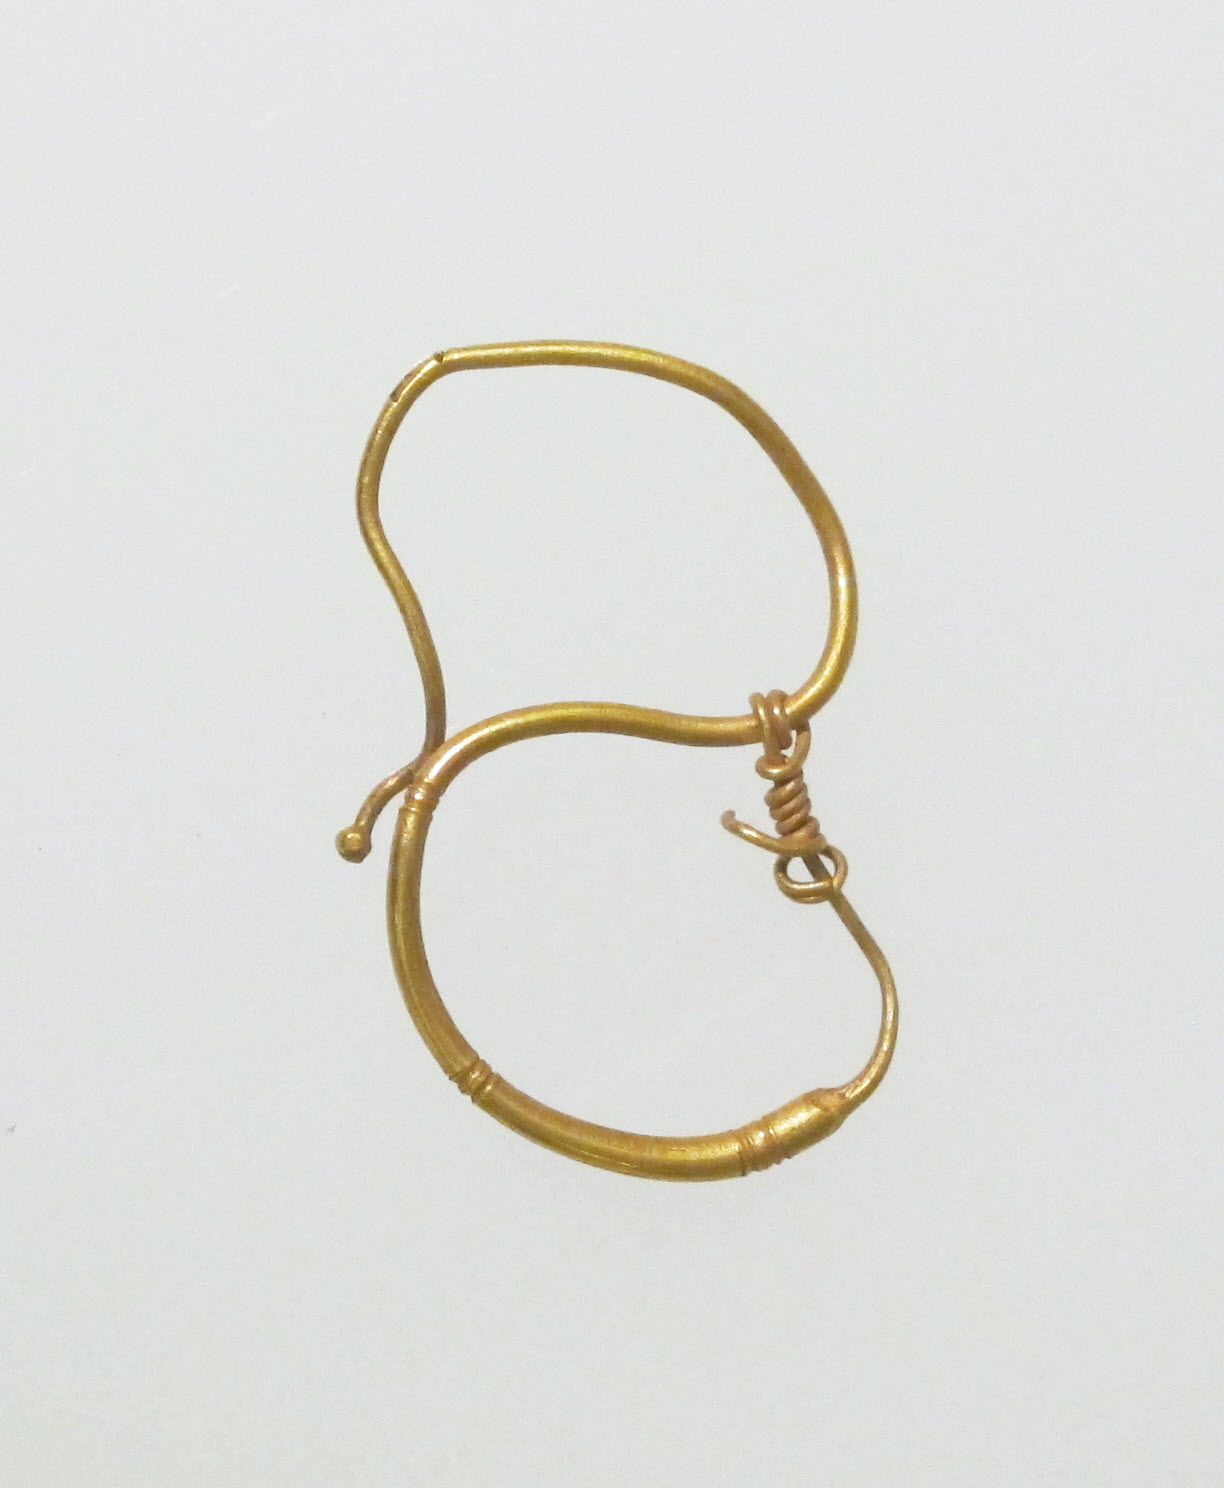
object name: earring, delta shaped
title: Earring, delta-shaped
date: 7000 BCE-330 CE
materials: gold